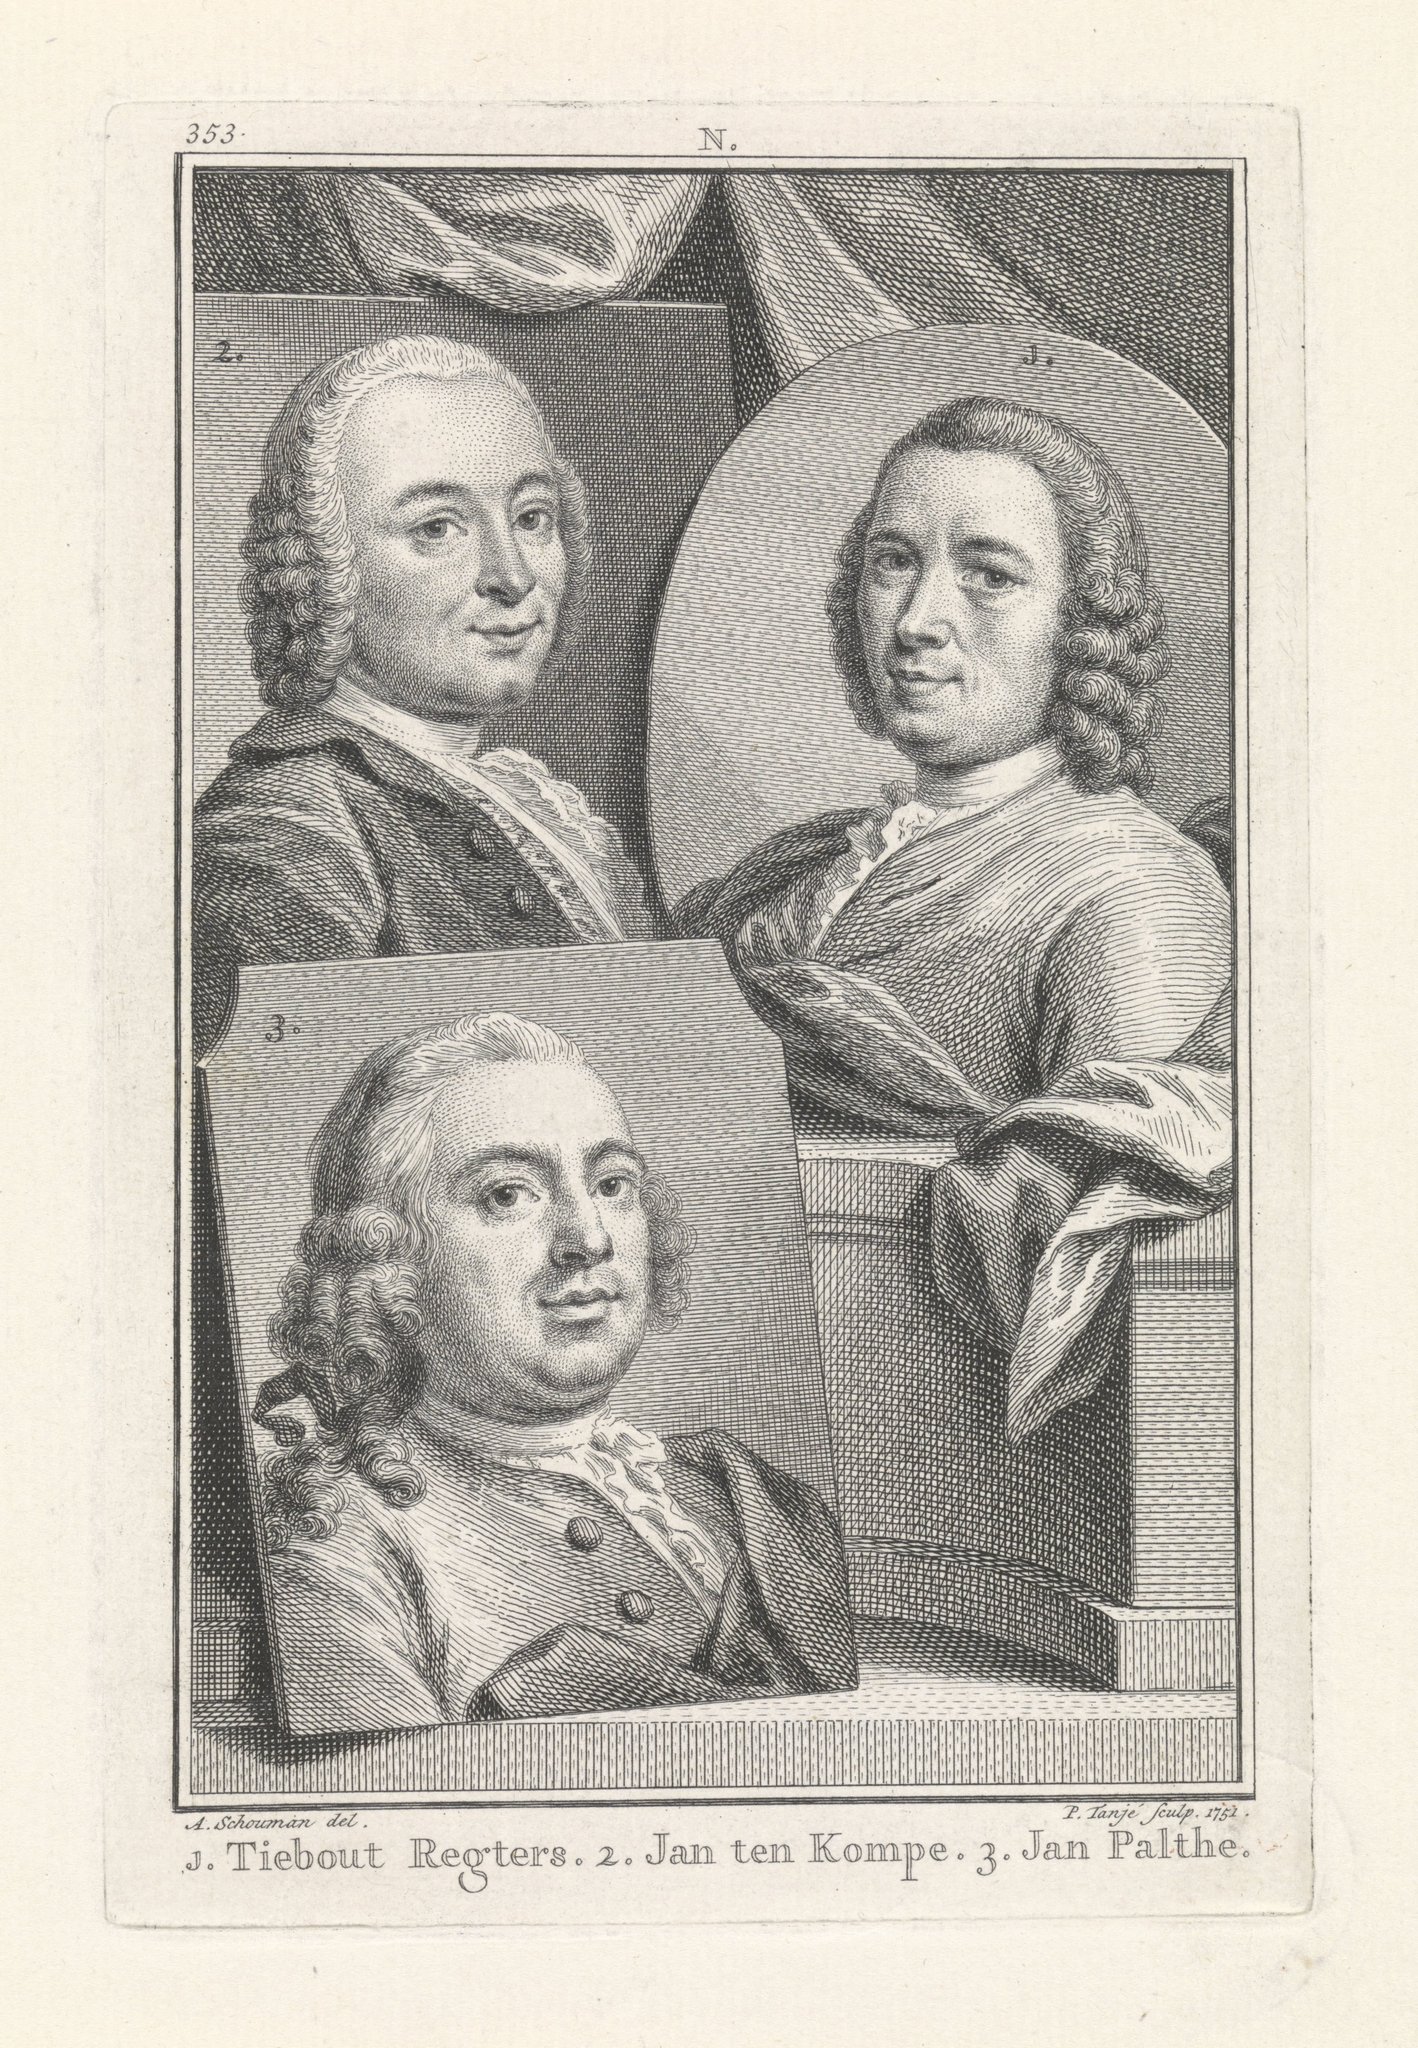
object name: print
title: Portretten van Tibout Regters, Jan ten Compe en Jan Palthe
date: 1751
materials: paper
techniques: engraving, etching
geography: amsterdam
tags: deventer, leiden, jan palthe, dordrecht, tibout regters, amsterdam, painter, draughtsman, jan ten compe, portrait, self-portrait of artist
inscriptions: collector's mark: Lugt 240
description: Prent uit: Gool, Johan van. De nieuwe schouburg der Nederlantsche kunstschilders en schilderessen. Den Haag 1751, dl. 2, p. 353.